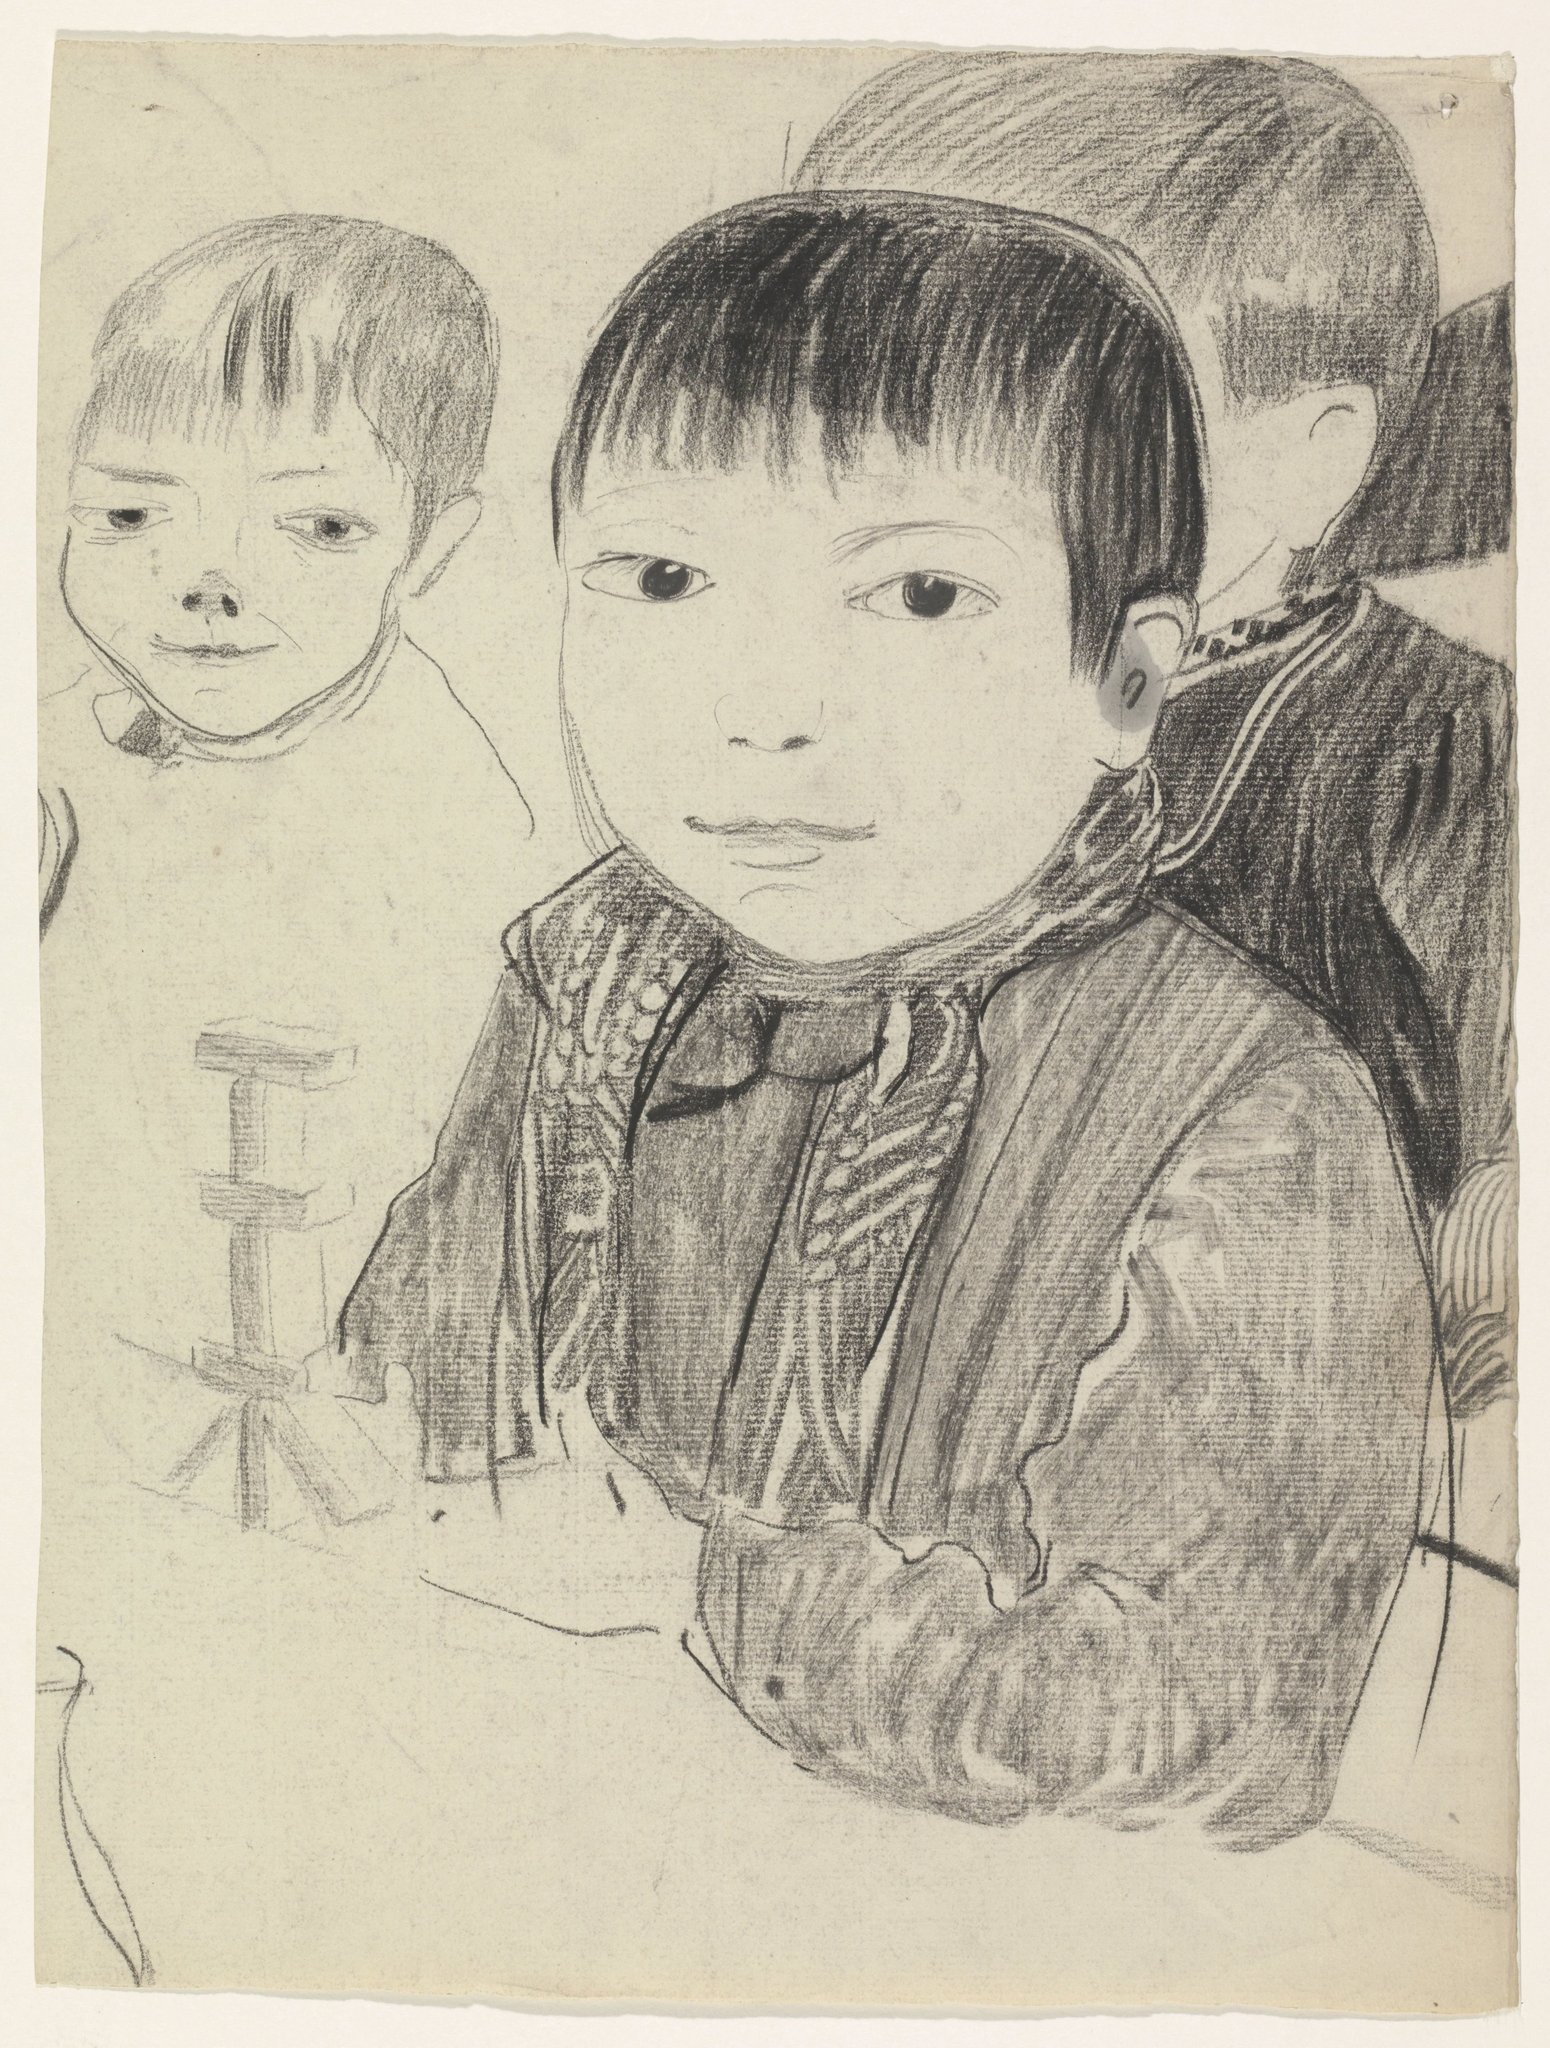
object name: drawing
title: Kinderen in de schoolbank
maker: carel adolph lion cachet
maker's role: draughtsman, print maker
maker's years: 1864-1945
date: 1874-1945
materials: chalk, paper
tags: elementary school; class, form